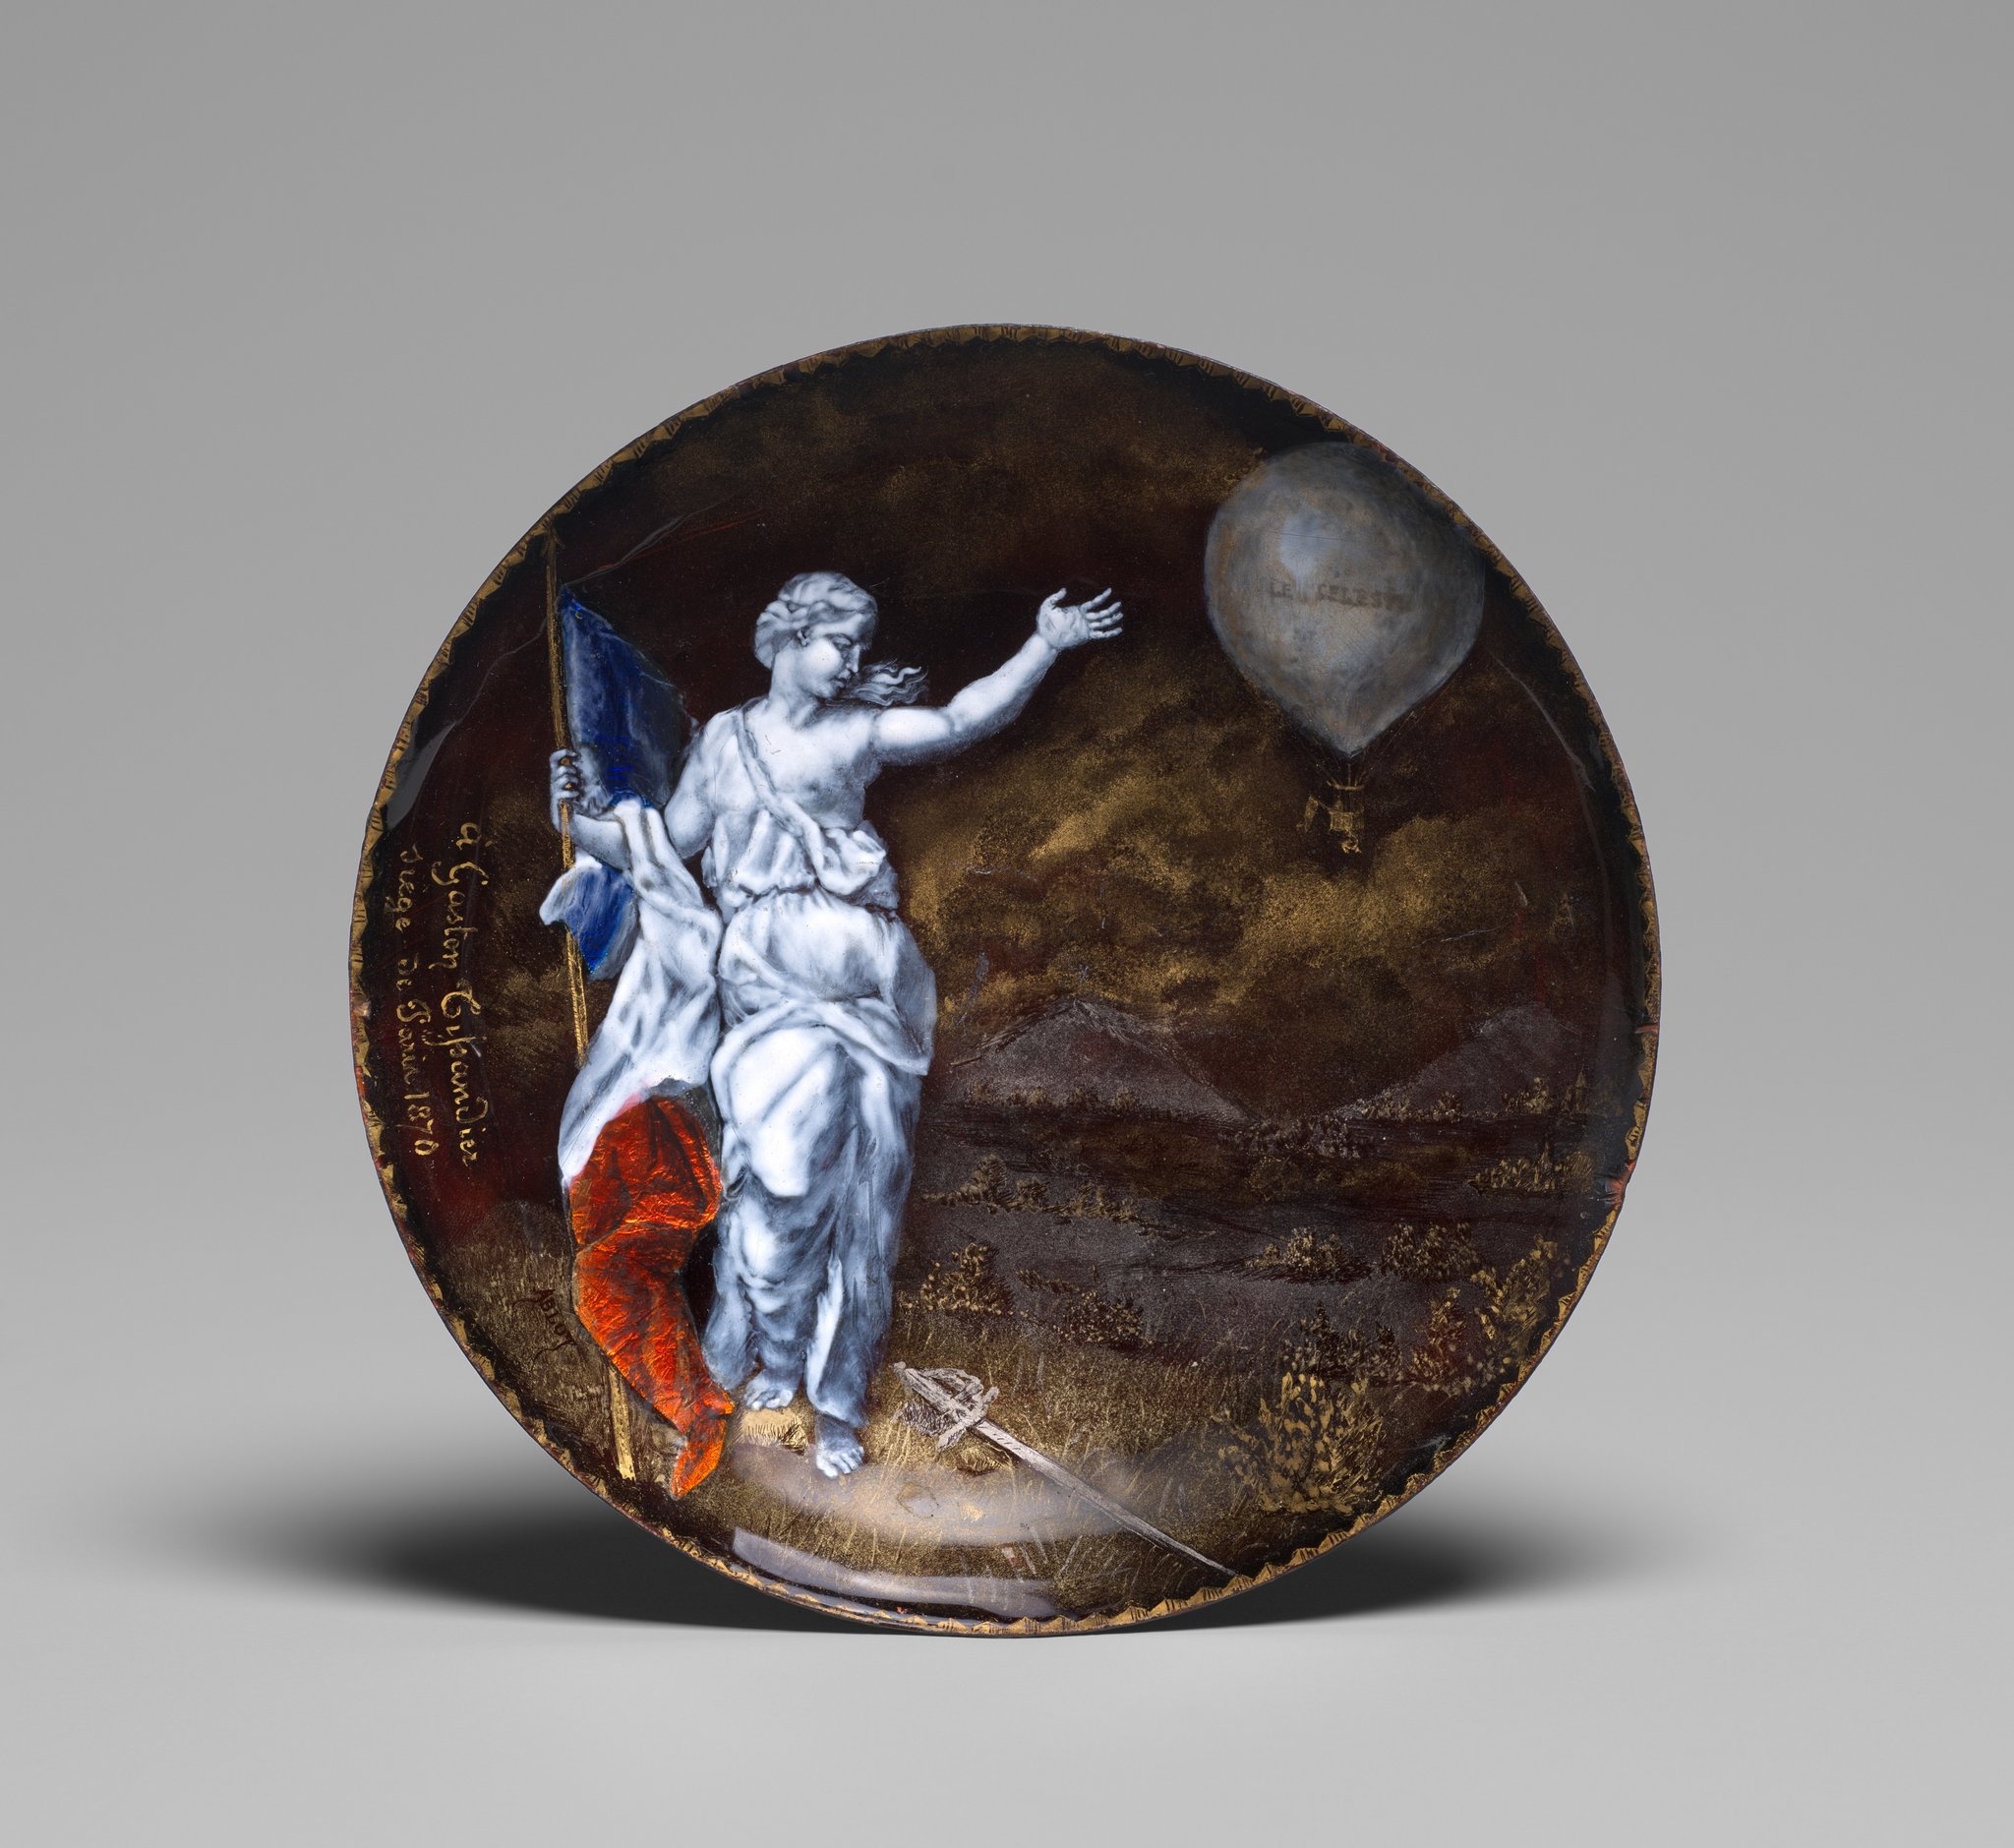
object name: bowl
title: Bowl honoring Gaston Tissandier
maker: joséphine arthurine blot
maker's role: enameler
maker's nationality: french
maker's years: 1842-1894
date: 1870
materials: copper, enamel, foil